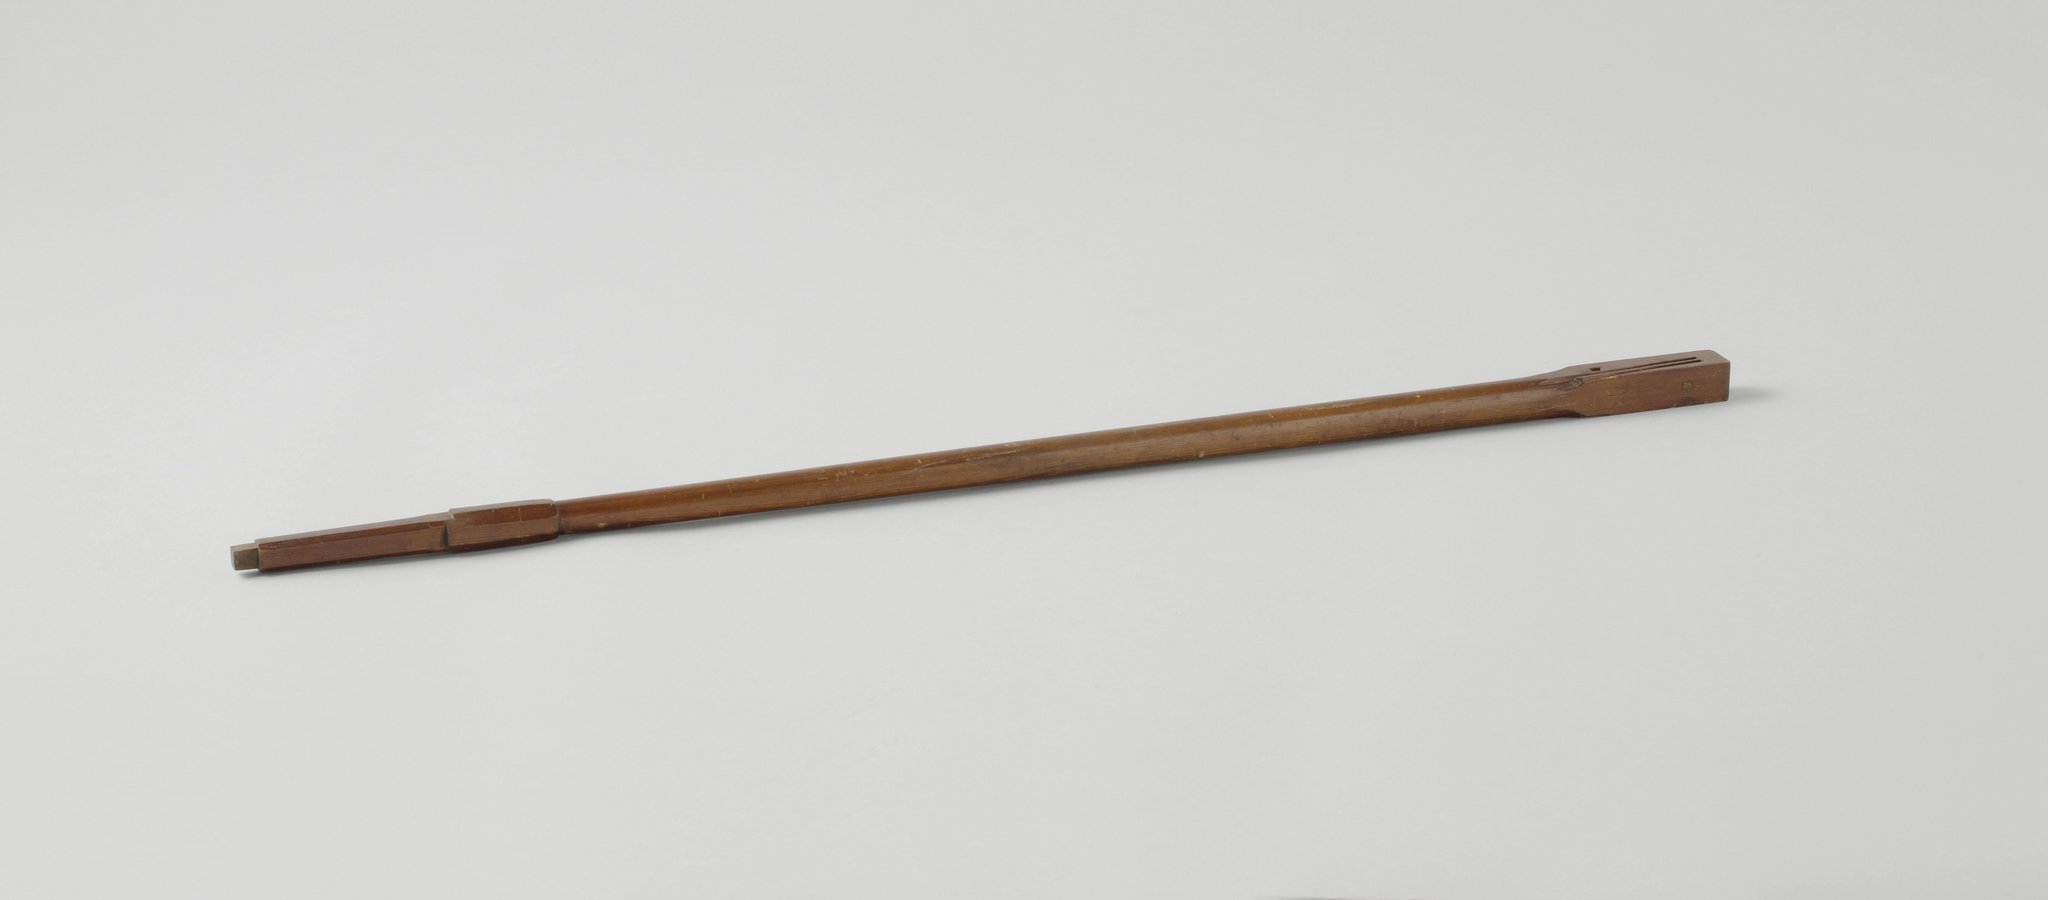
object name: demonstration model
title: Model of a Main Topmast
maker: Anonymous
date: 1850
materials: brass, wood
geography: netherlands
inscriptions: label, centre: ‘152’ former inventory label, inscription, on the square heeling: ‘E’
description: Dit model stelt de grote steng van de Piet Hein voor, in 1833 als linieschip op stapel gezet, uiteengenomen en in 1853-1856 als eerste Nederlands schroefstoomfregat afgebouwd door A.E. Tromp in Amsterdam, lang 59.62 m en herdoopt de Admiraal van Wassenaer. Samen met een aantal andere modellen van rondhouten kan de gehele grote mast gevormd worden.